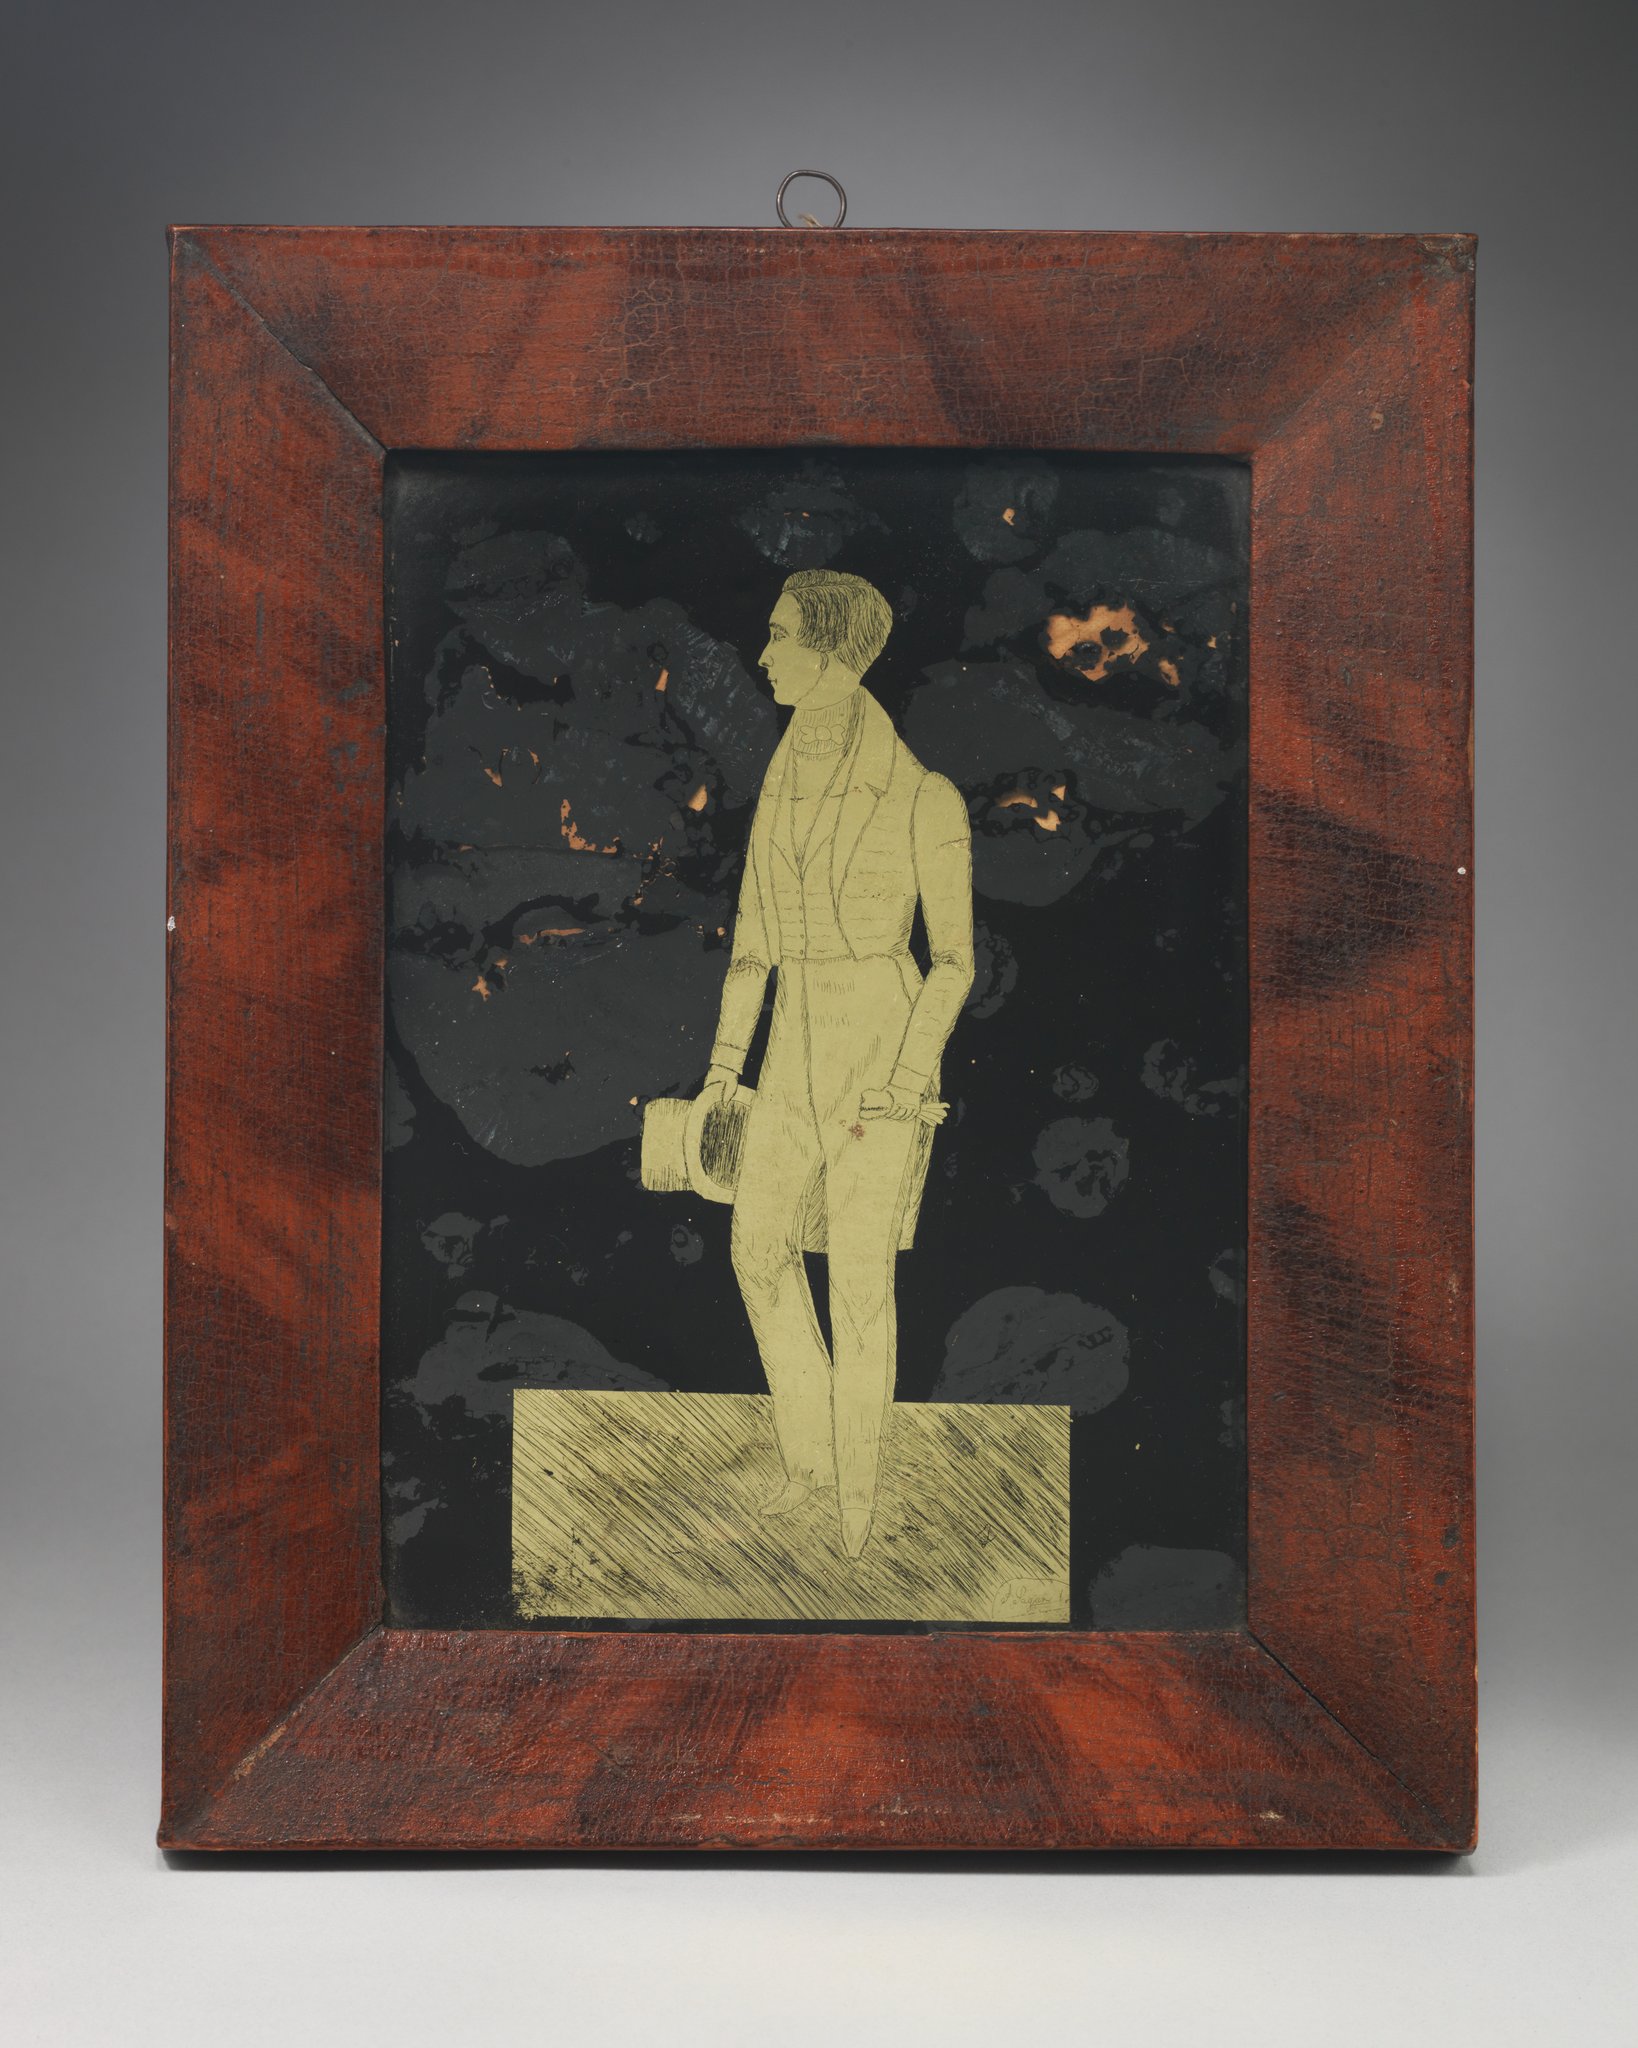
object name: panel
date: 1801-1900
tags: men